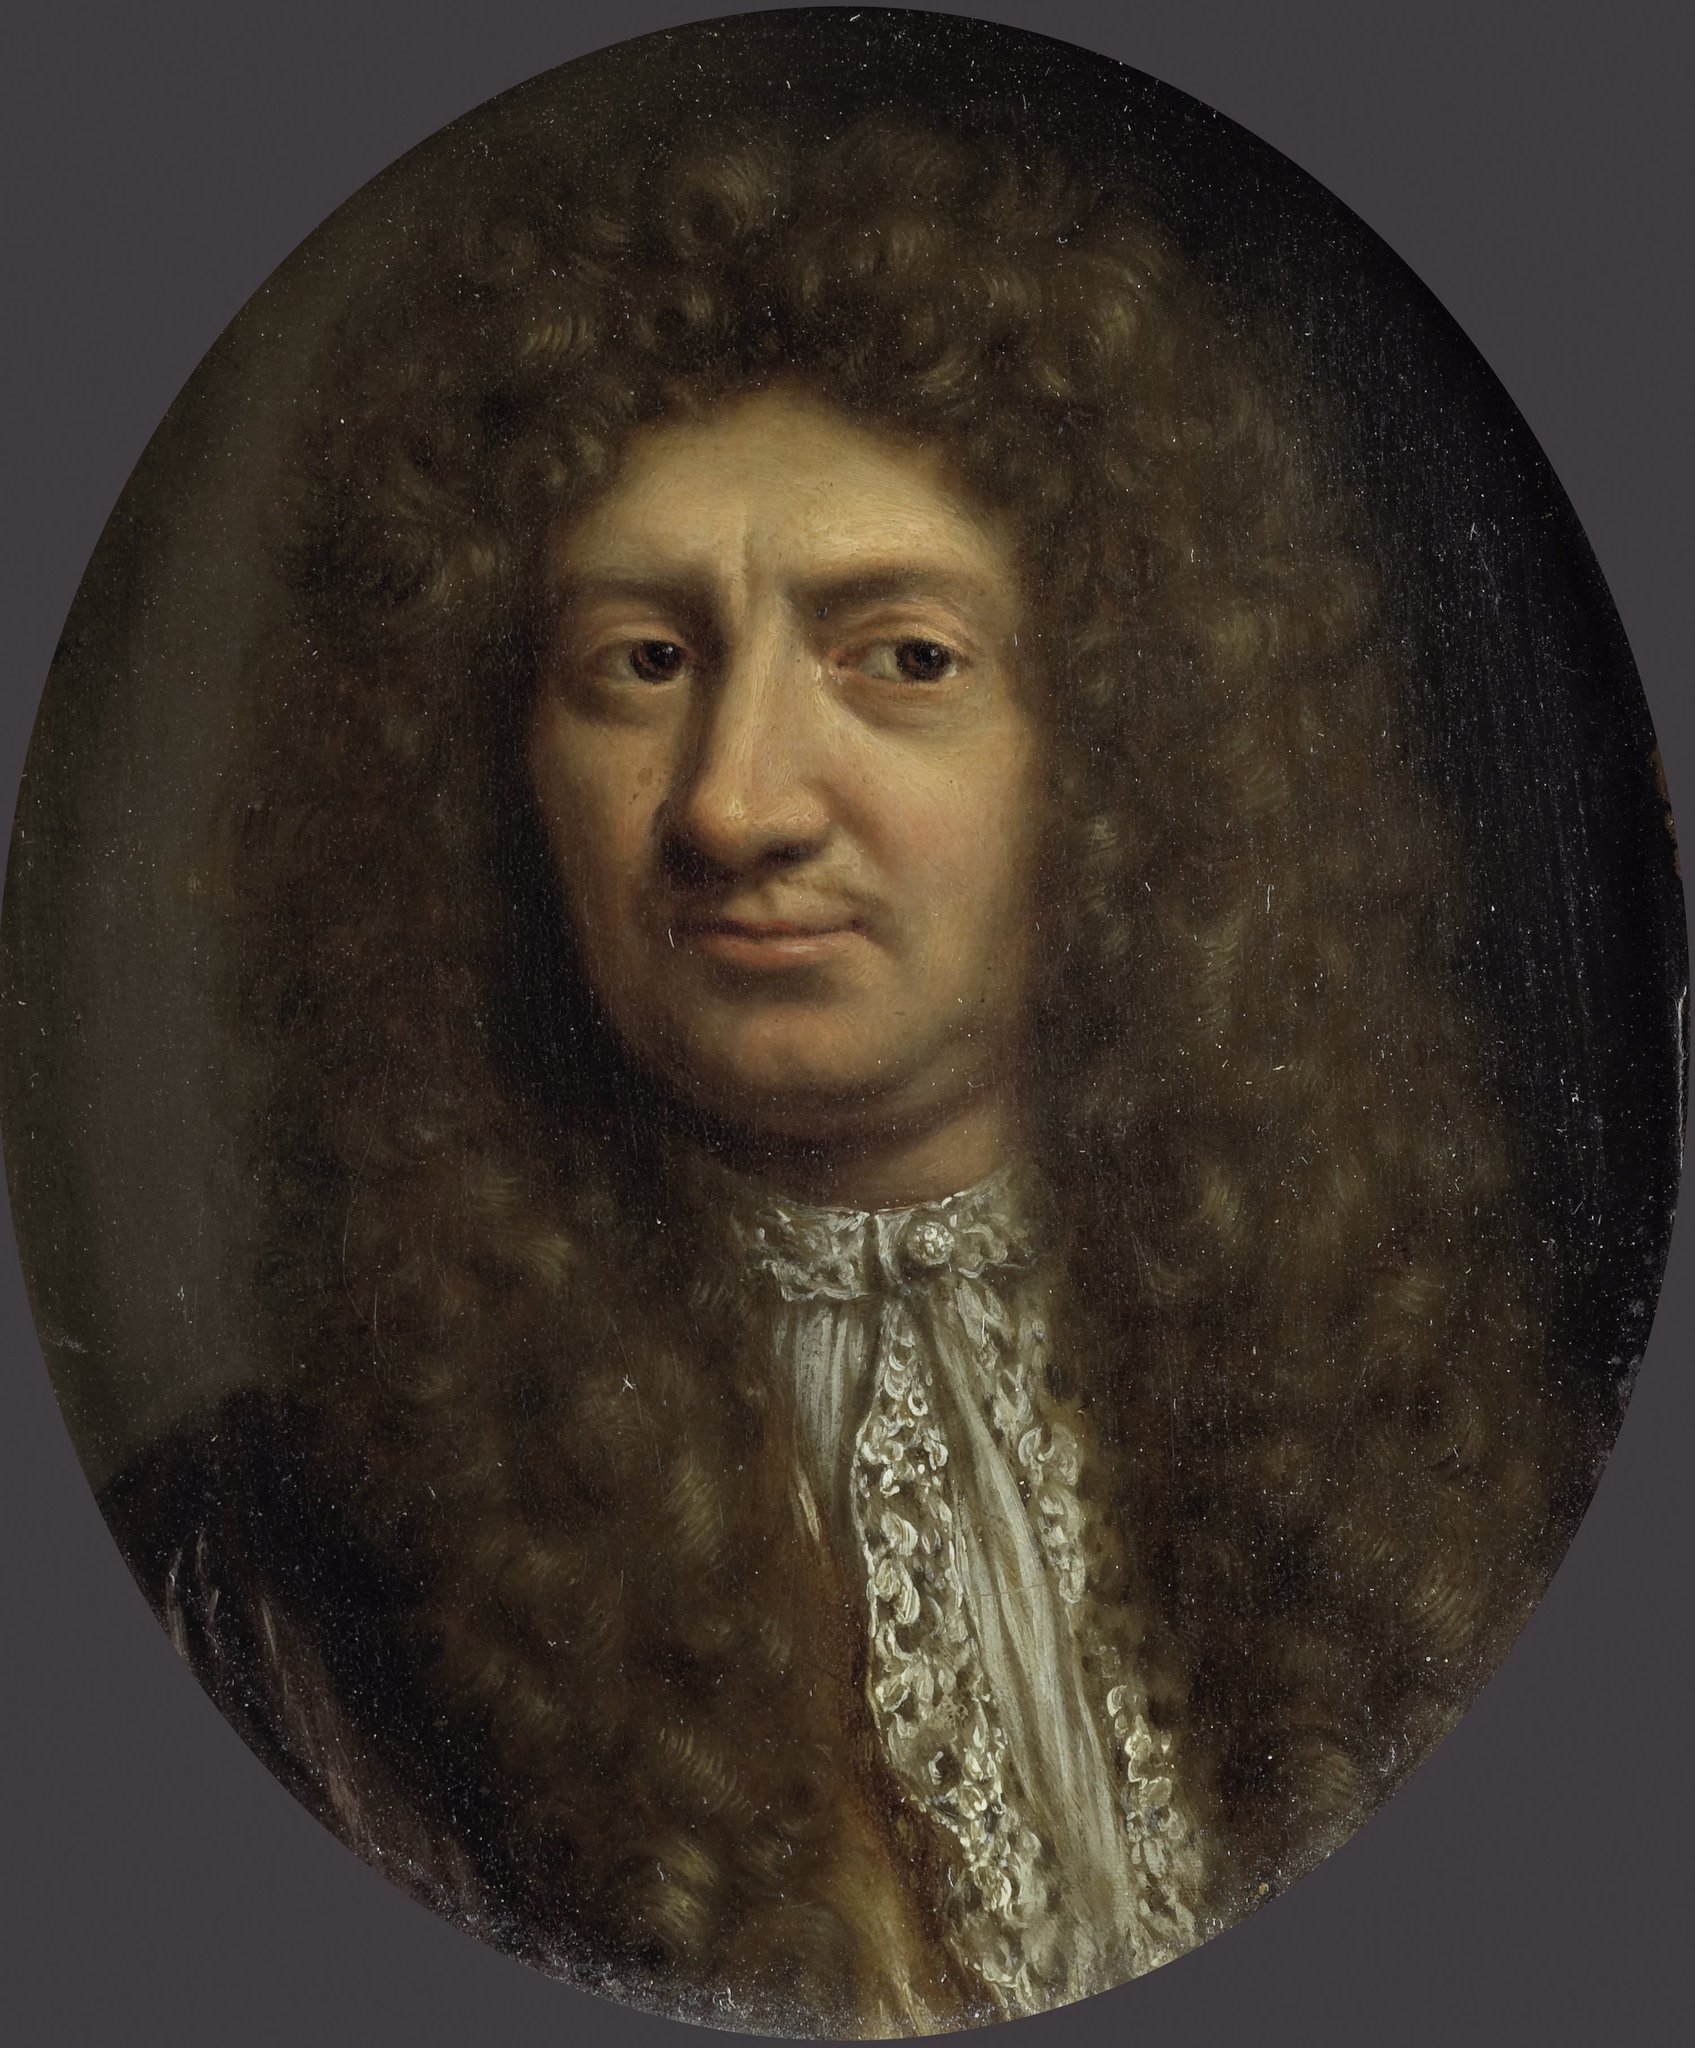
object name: painting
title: Portrait of a Man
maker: willem van mieris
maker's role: draughtsman, painter, print maker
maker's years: 1662-1747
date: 1660-1681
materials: copper, oil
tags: anonymous historical person portrayed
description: Portret van een onbekende man, de kop en face.